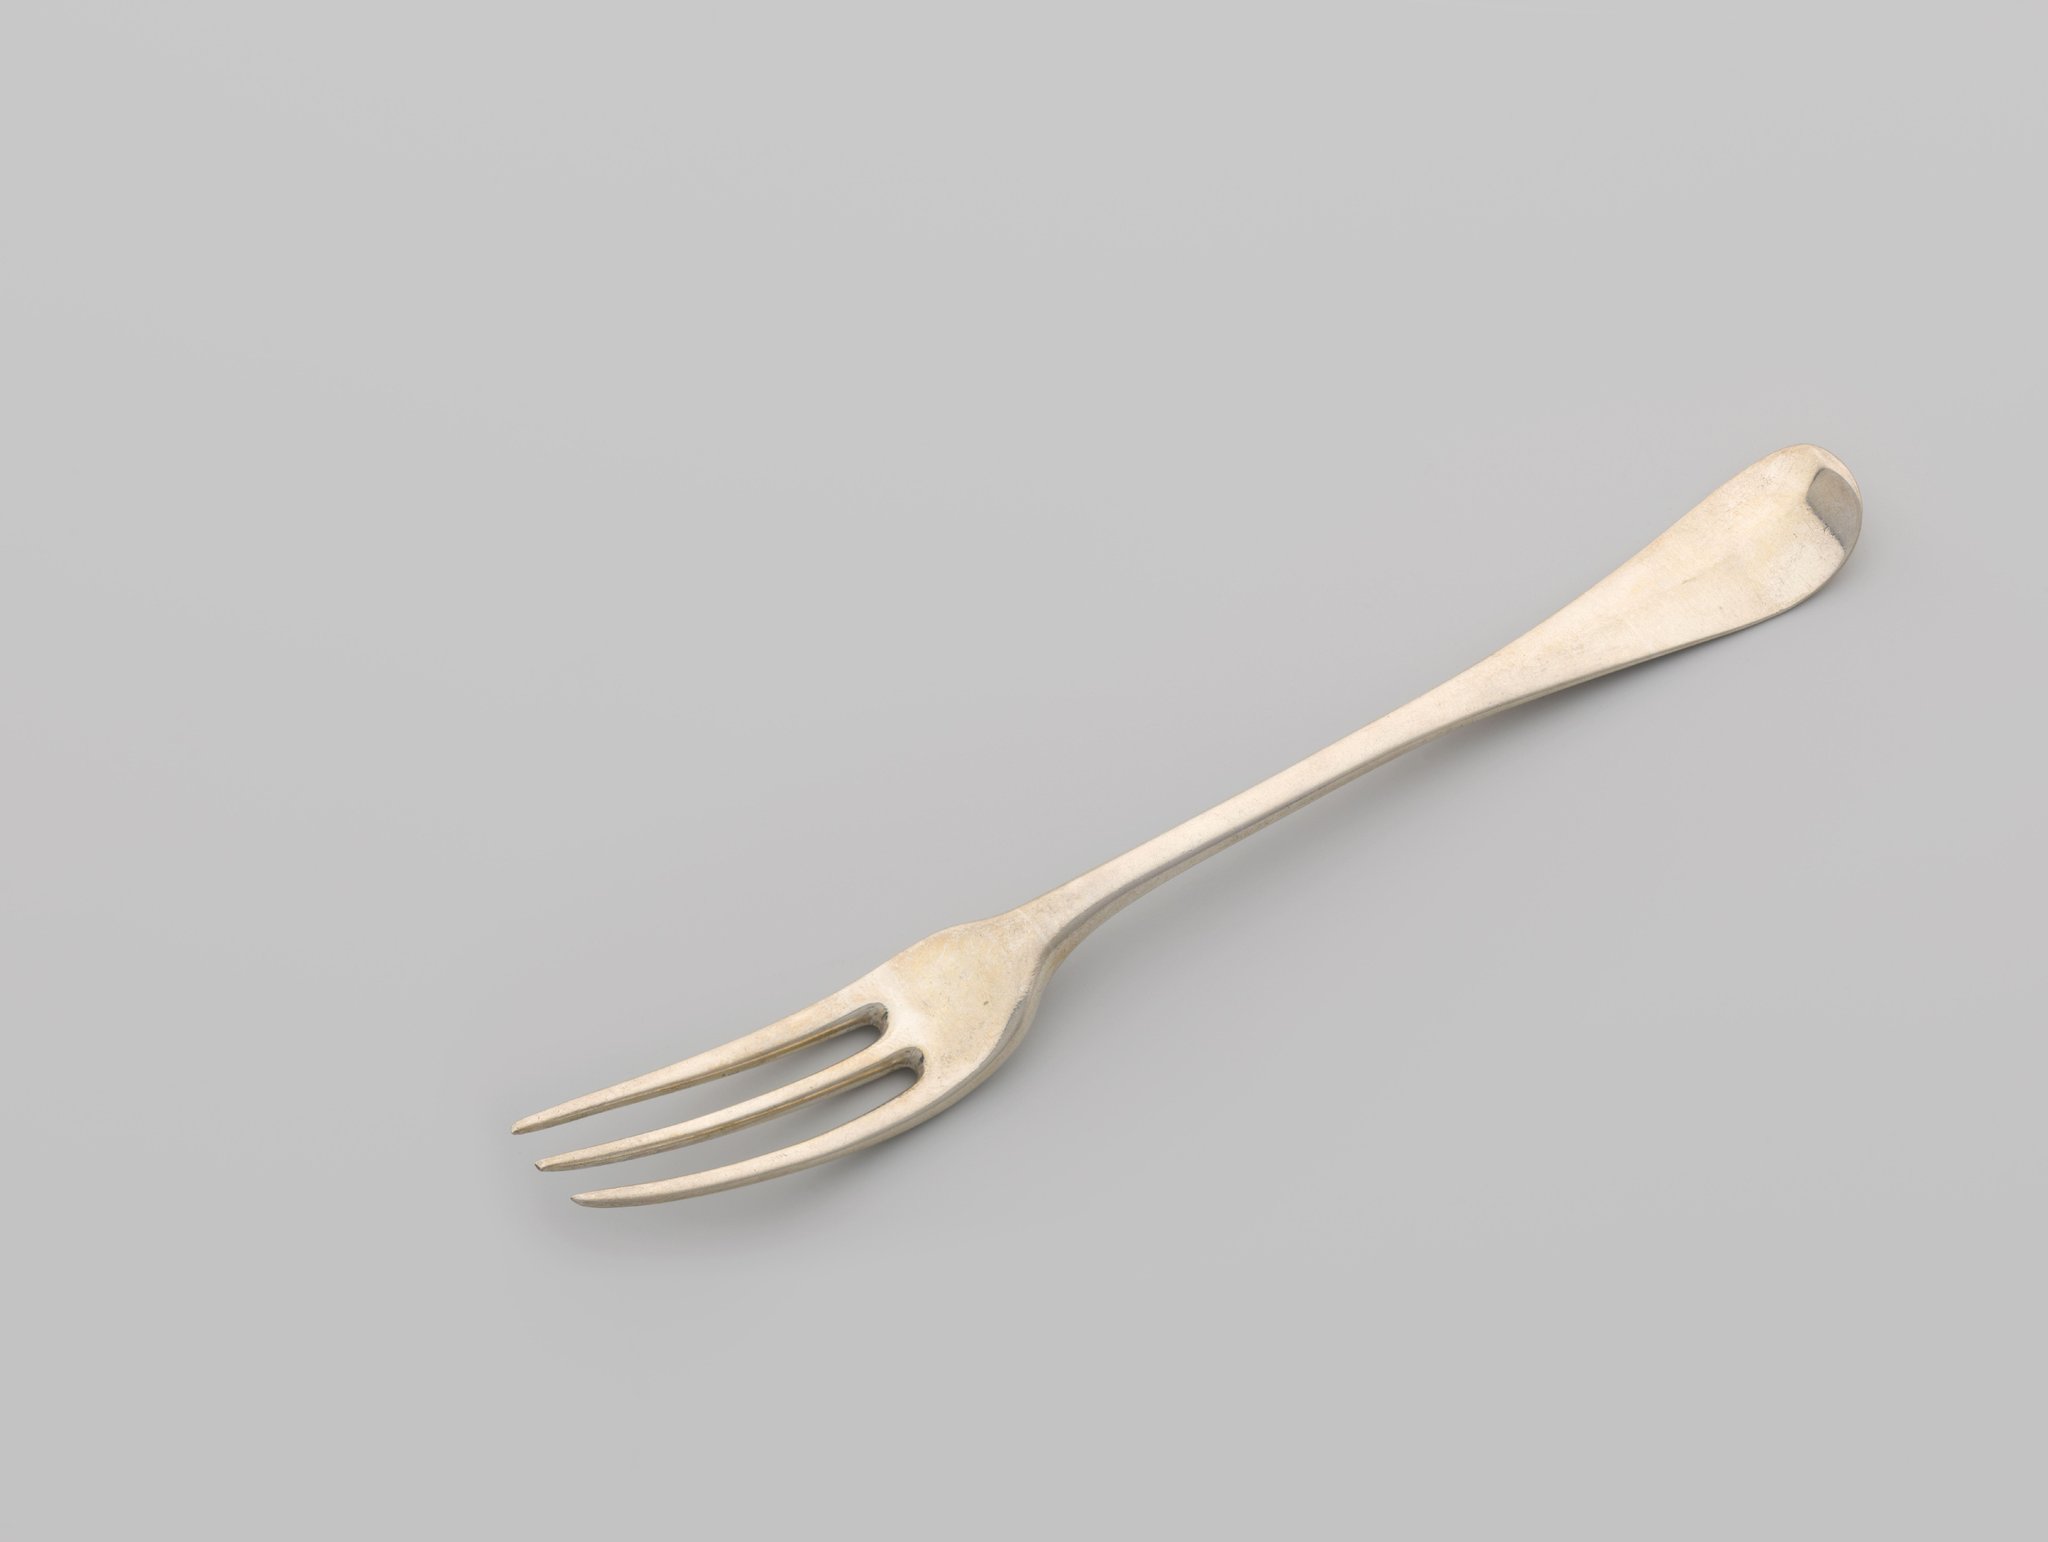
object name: dessert fork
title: Dessertvork met het helmteken Clifford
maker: cornelis loeff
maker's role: silversmith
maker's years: 1738-1793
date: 1793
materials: silver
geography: amsterdam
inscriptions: maker's mark, date letter: ‘I’, town mark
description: De drietandige vork is door middel van enkel lof verbonden met de platte, gebogen steel, die zich verbreedt naar het afgeronde uiteinde en die aan de bovenzijde over het midden een flauwe ribbel vertoont. Op de onderzijde van de steel is het helmteken Clifford gegraveerd.